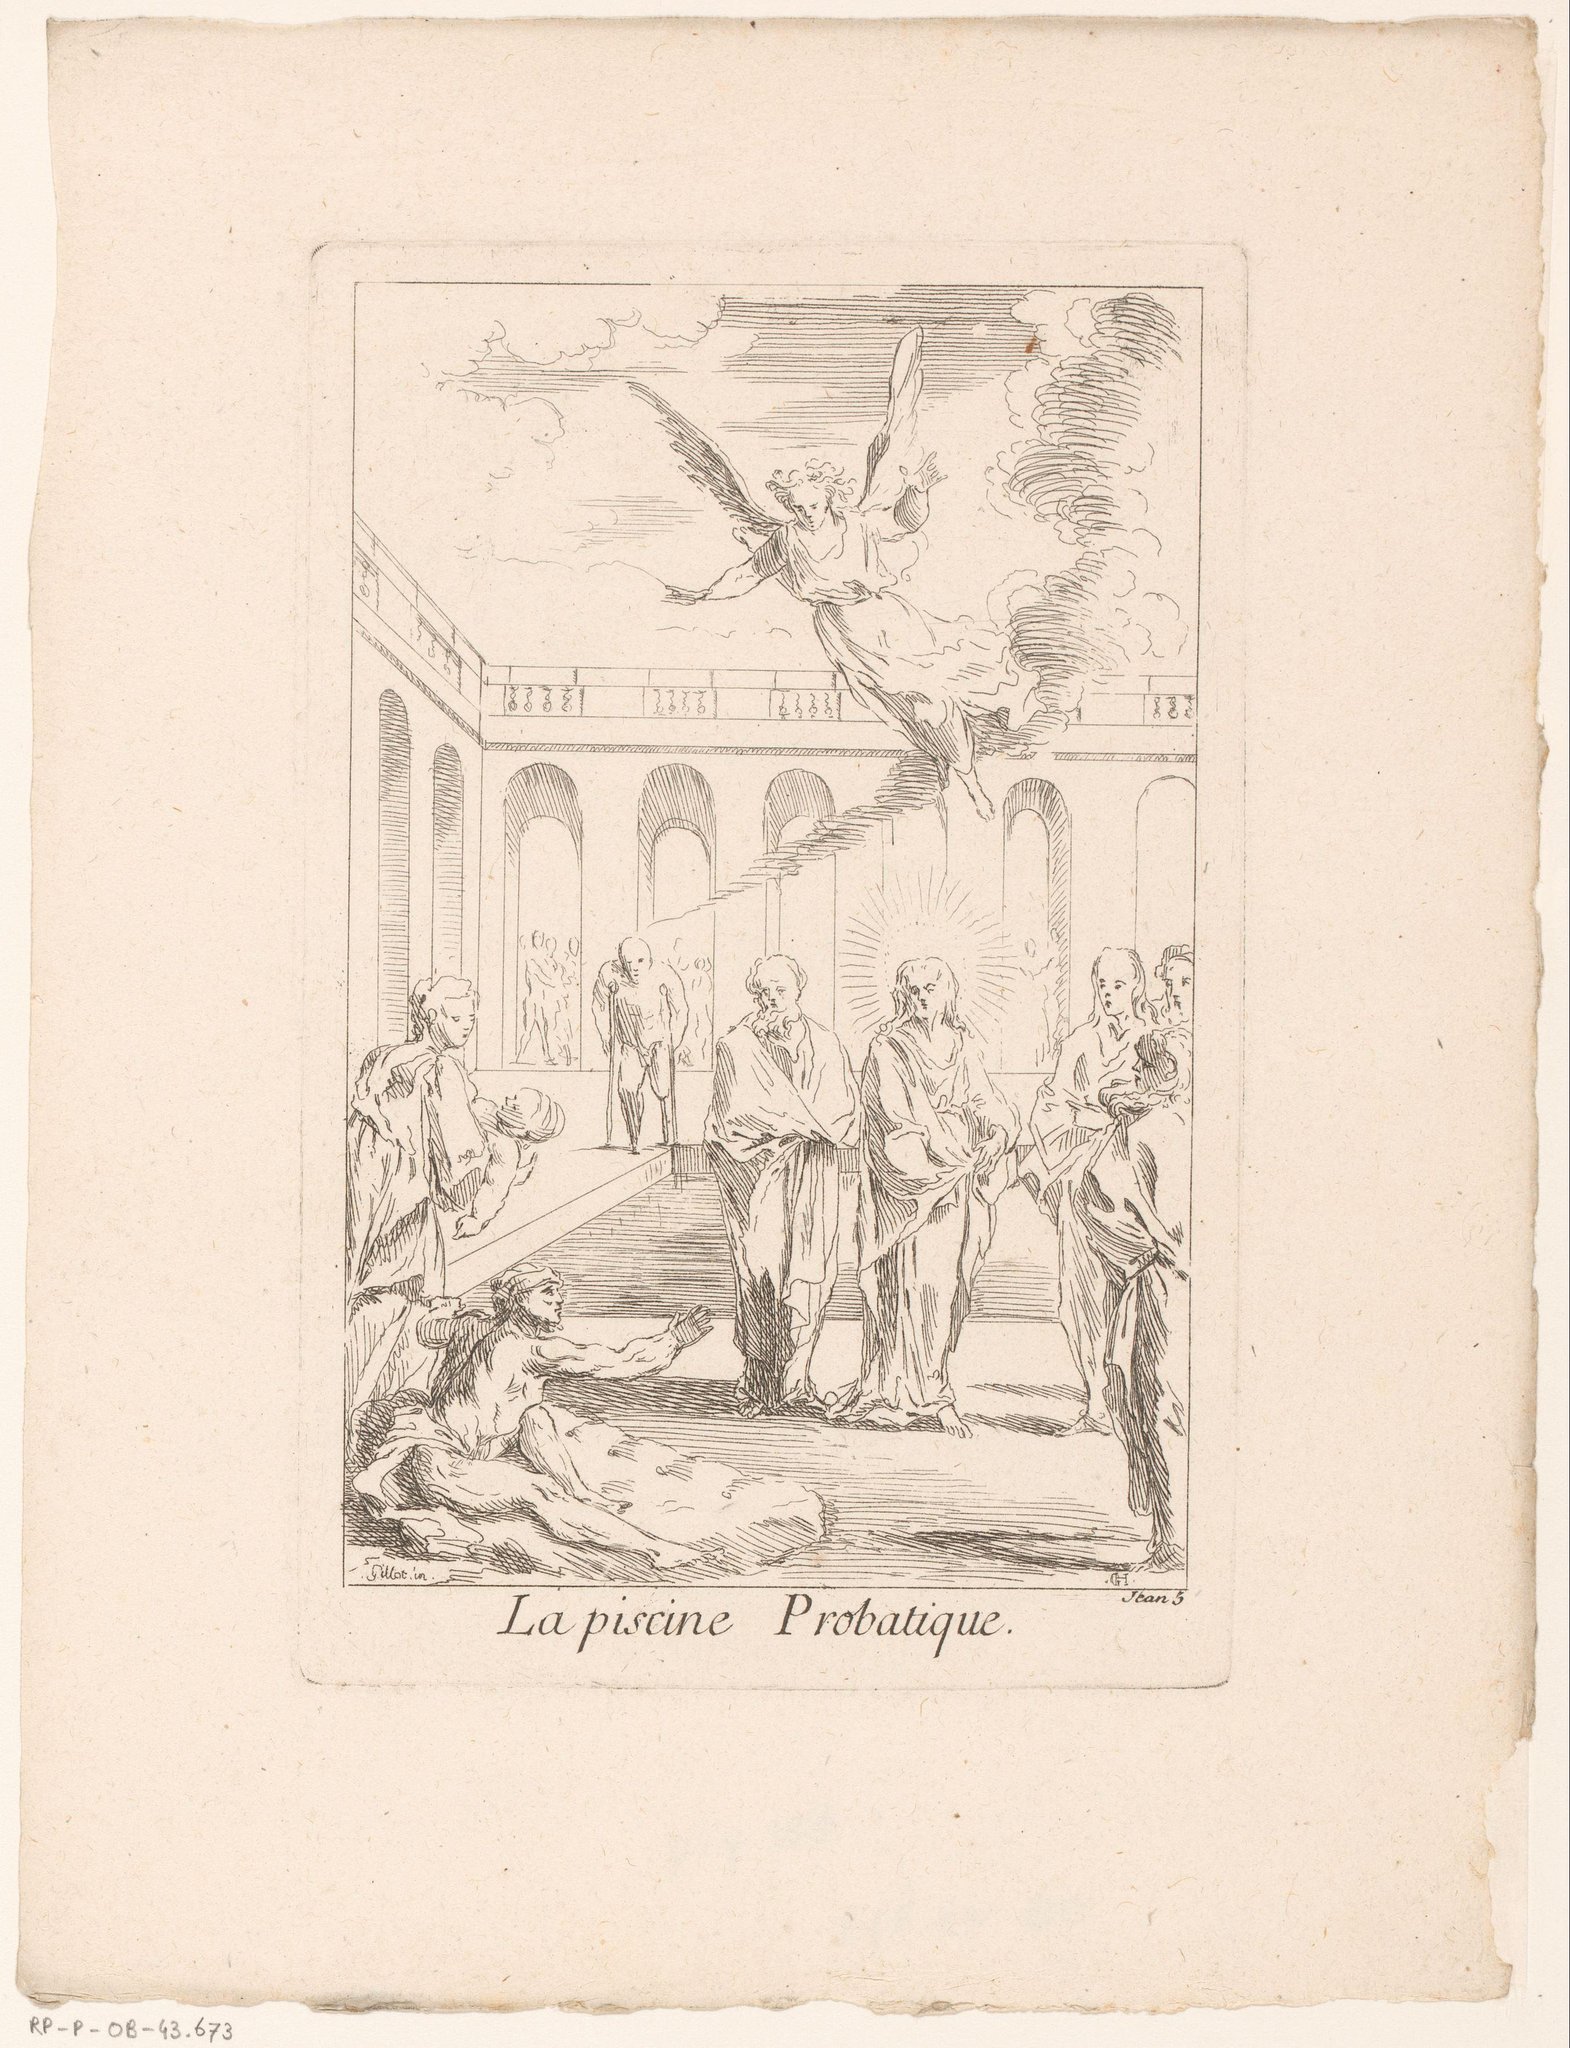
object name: print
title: La piscine Probatique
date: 1705-1732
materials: paper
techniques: etching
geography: paris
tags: sick people lying near the pool of bethesda ~ christ healing paralytics (john 5:1-9)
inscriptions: collector's mark: Lugt 2228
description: Maakt deel uit van een serie met zestig prenten met als thema het leven van Christus.